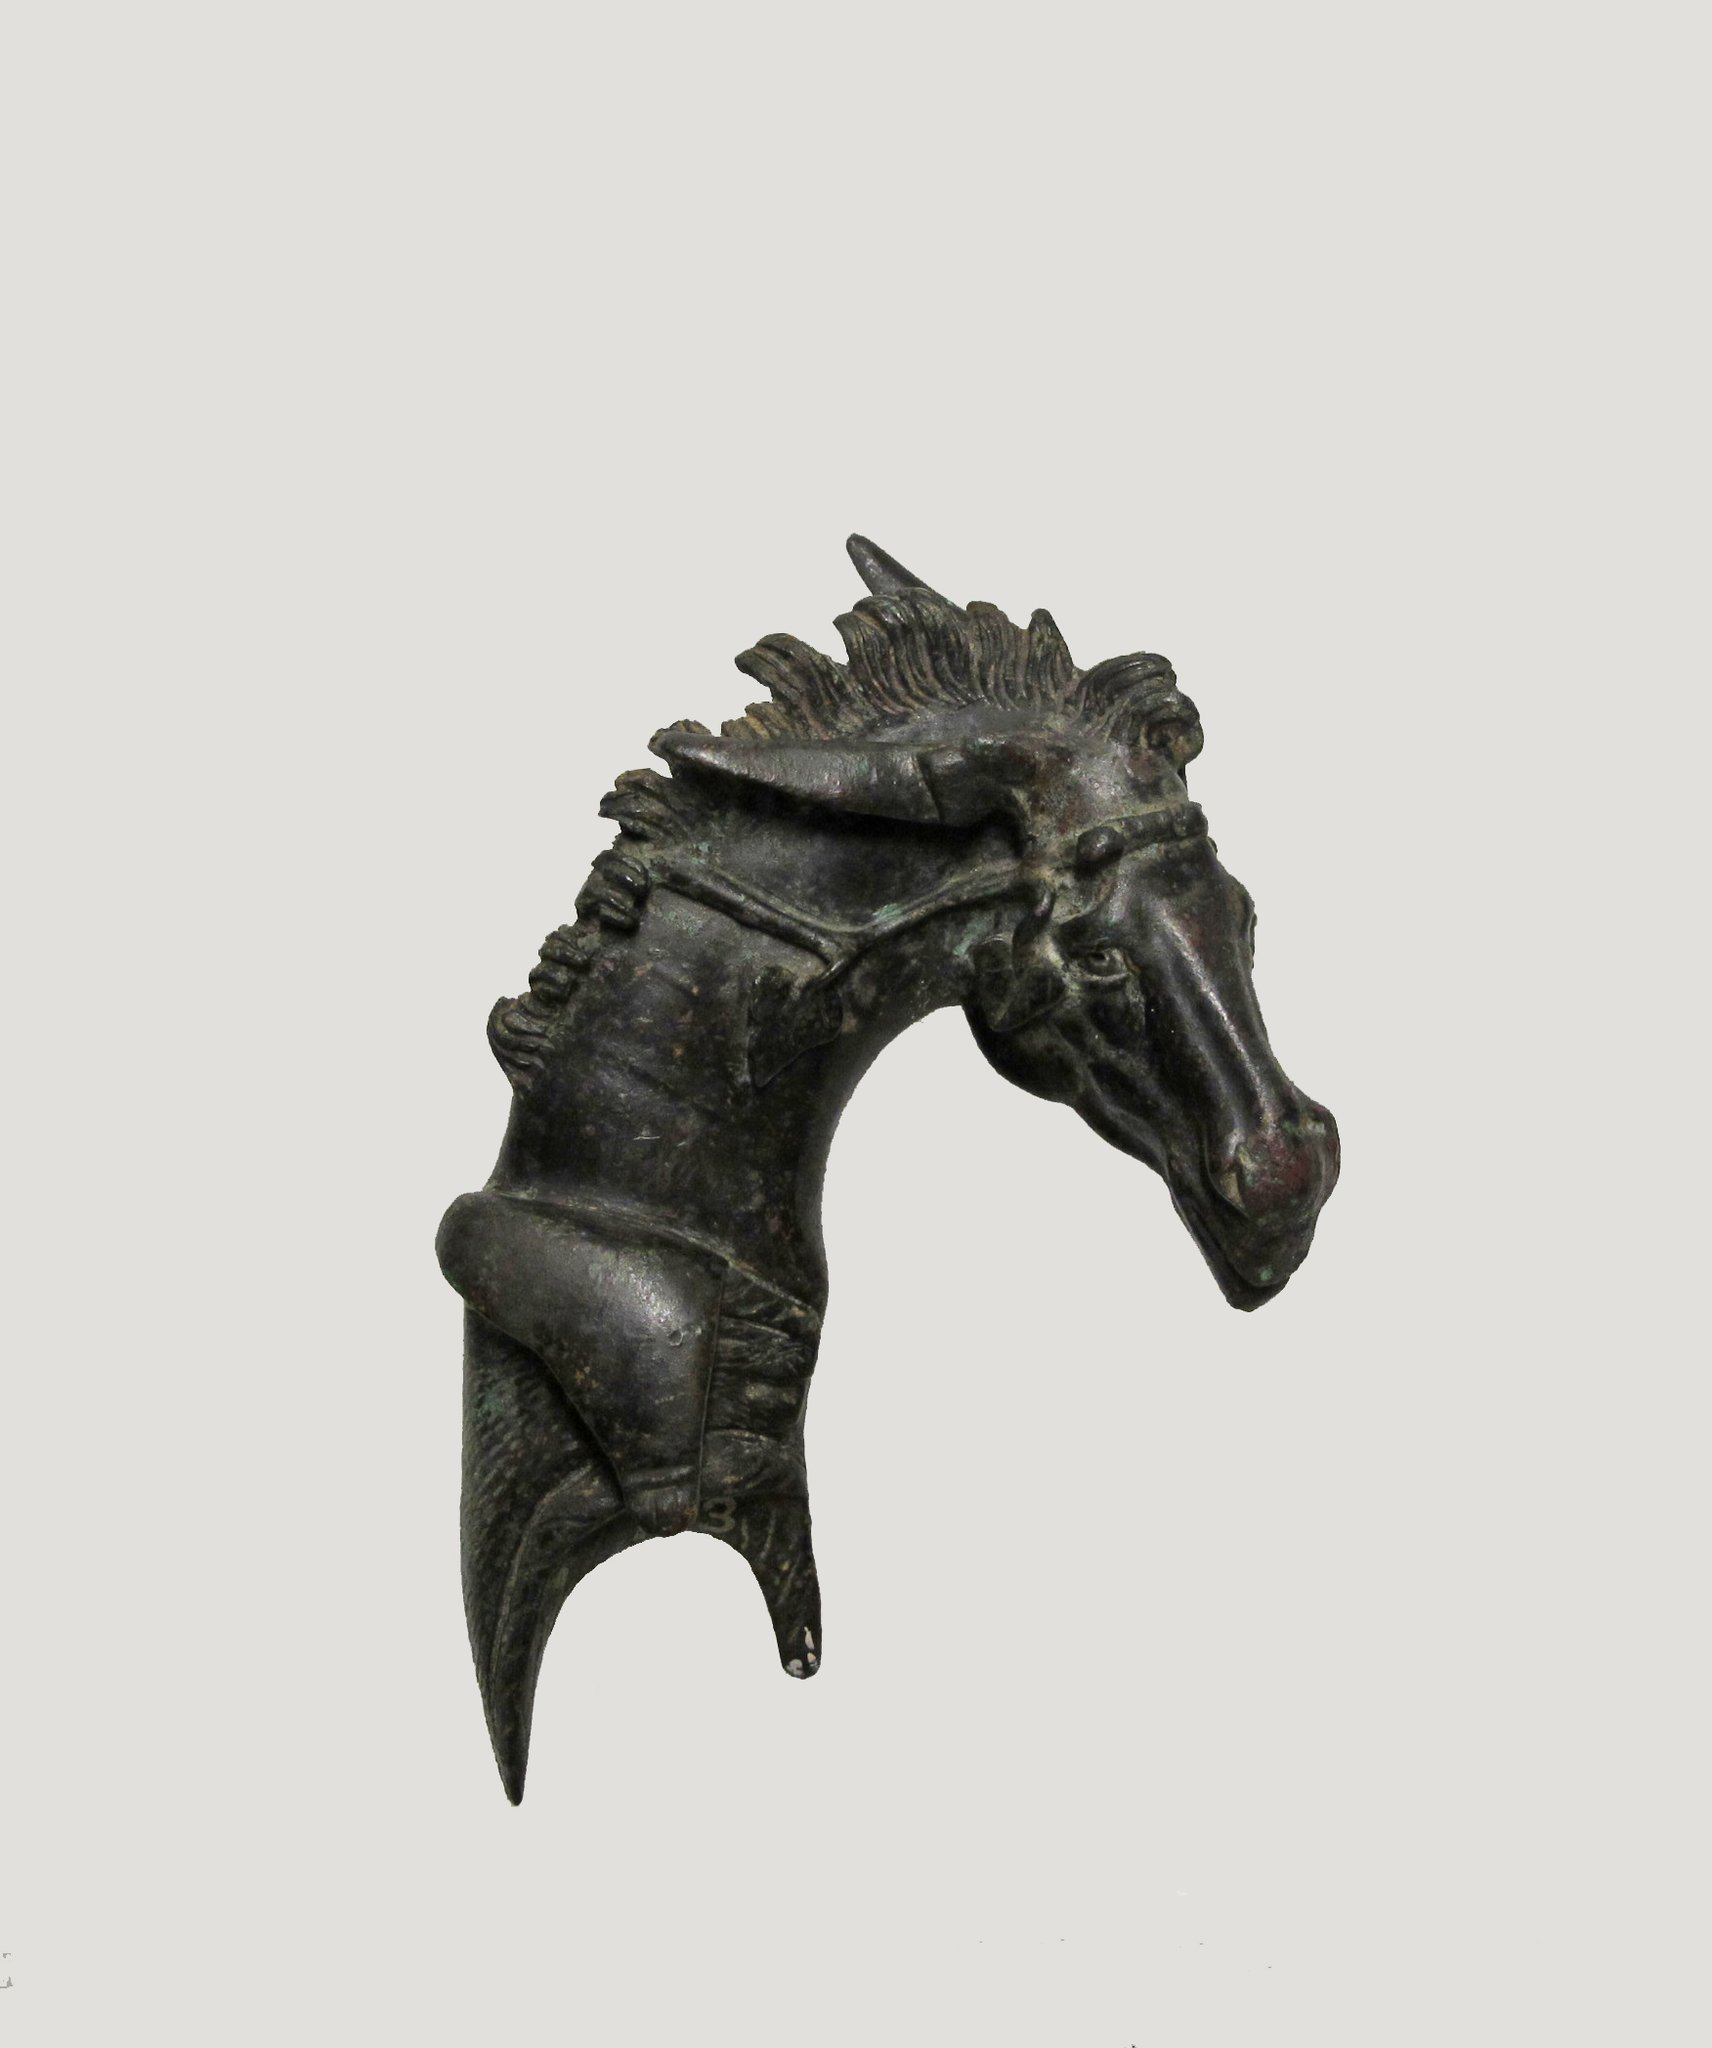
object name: furniture attachment, head of a mule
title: Two fulcra (headrest) attachments in the form of mule's heads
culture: greek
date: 234-1 BCE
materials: bronze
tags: animals